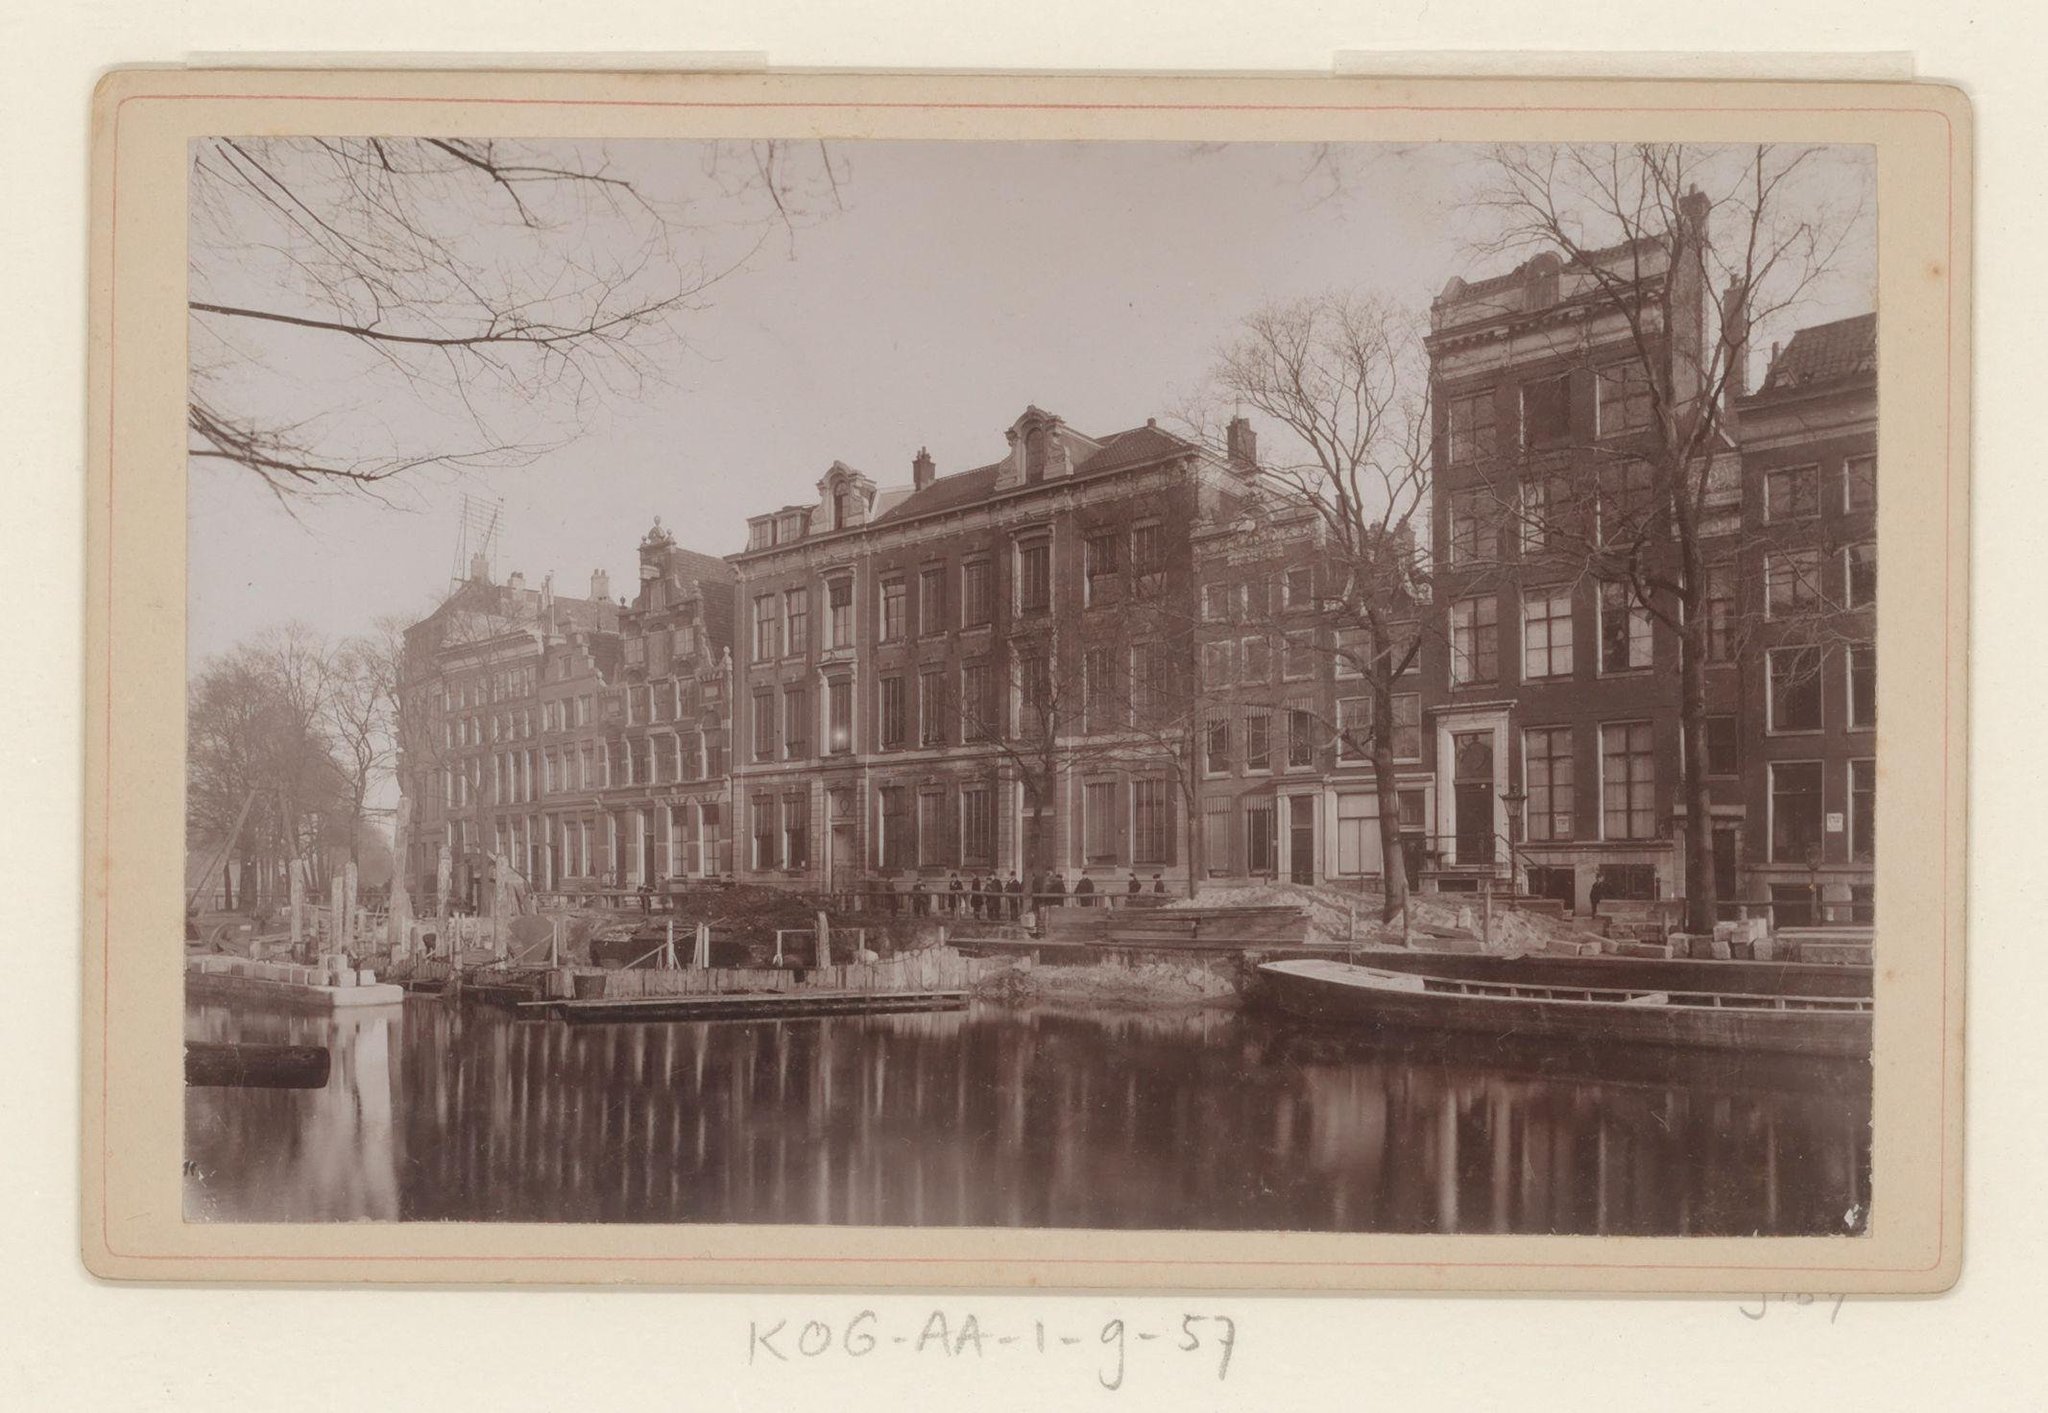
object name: cabinet photograph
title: Gezicht op de Keizersgracht bij de Westermarkt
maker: Anonymous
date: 1865-1940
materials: paper, cardboard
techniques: collodion silver print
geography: amsterdam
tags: city-view in general; 'veduta', canal, tow-boat, towing-barge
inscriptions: collector's mark: ‘9.57’ Lugt 1641b, inscription: ‘96. / Keizersgracht o/d Westermarkt v/d / afbraak.’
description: Onderwerpsrubriek binnen de Atlas Amsterdam: Kadijksplein, Karthuizerkerkhof, Kattegat, Kattenburg, Kapelsteeg O.Z., Enge Kerksteeg, Kerkstraat, Kinkerstraat, Kolk O.Z., Koningsplein, Kromboomsloot [Krom Boomssloot], Kostverlorenkade, Kwakersdwarspad, Kalverstraat, Keizersgracht (v.d. Brouwersgracht – Amstel), Klerensloot (Gedempte), Klimopstraat, Kloveniersburgwal, Kraansluis.